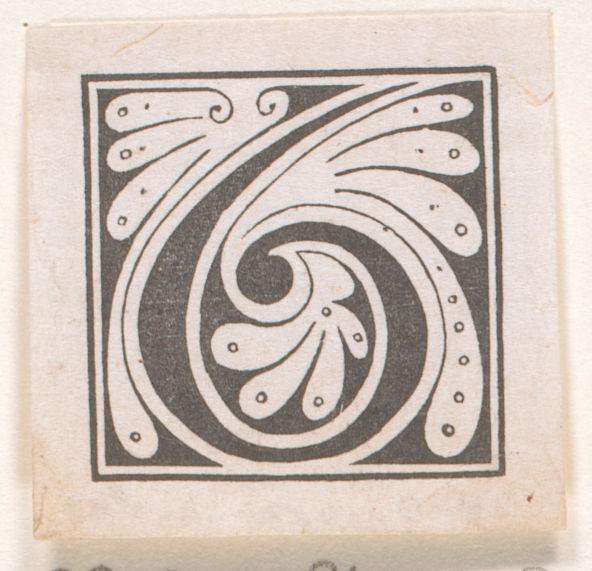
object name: photomechanical print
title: Getal 6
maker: reinier willem petrus de vries (1874-1953)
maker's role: draughtsman, print maker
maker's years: 1874-1953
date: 1904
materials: paper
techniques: printing block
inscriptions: collector's mark: ‘R:MVS.’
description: Het getal is gebruikt voor: Veth, Jan. Jozef Israëls en zijn kunst. Arnhem en Nijmegen: Gebroeders E&M Cohen, 1904.